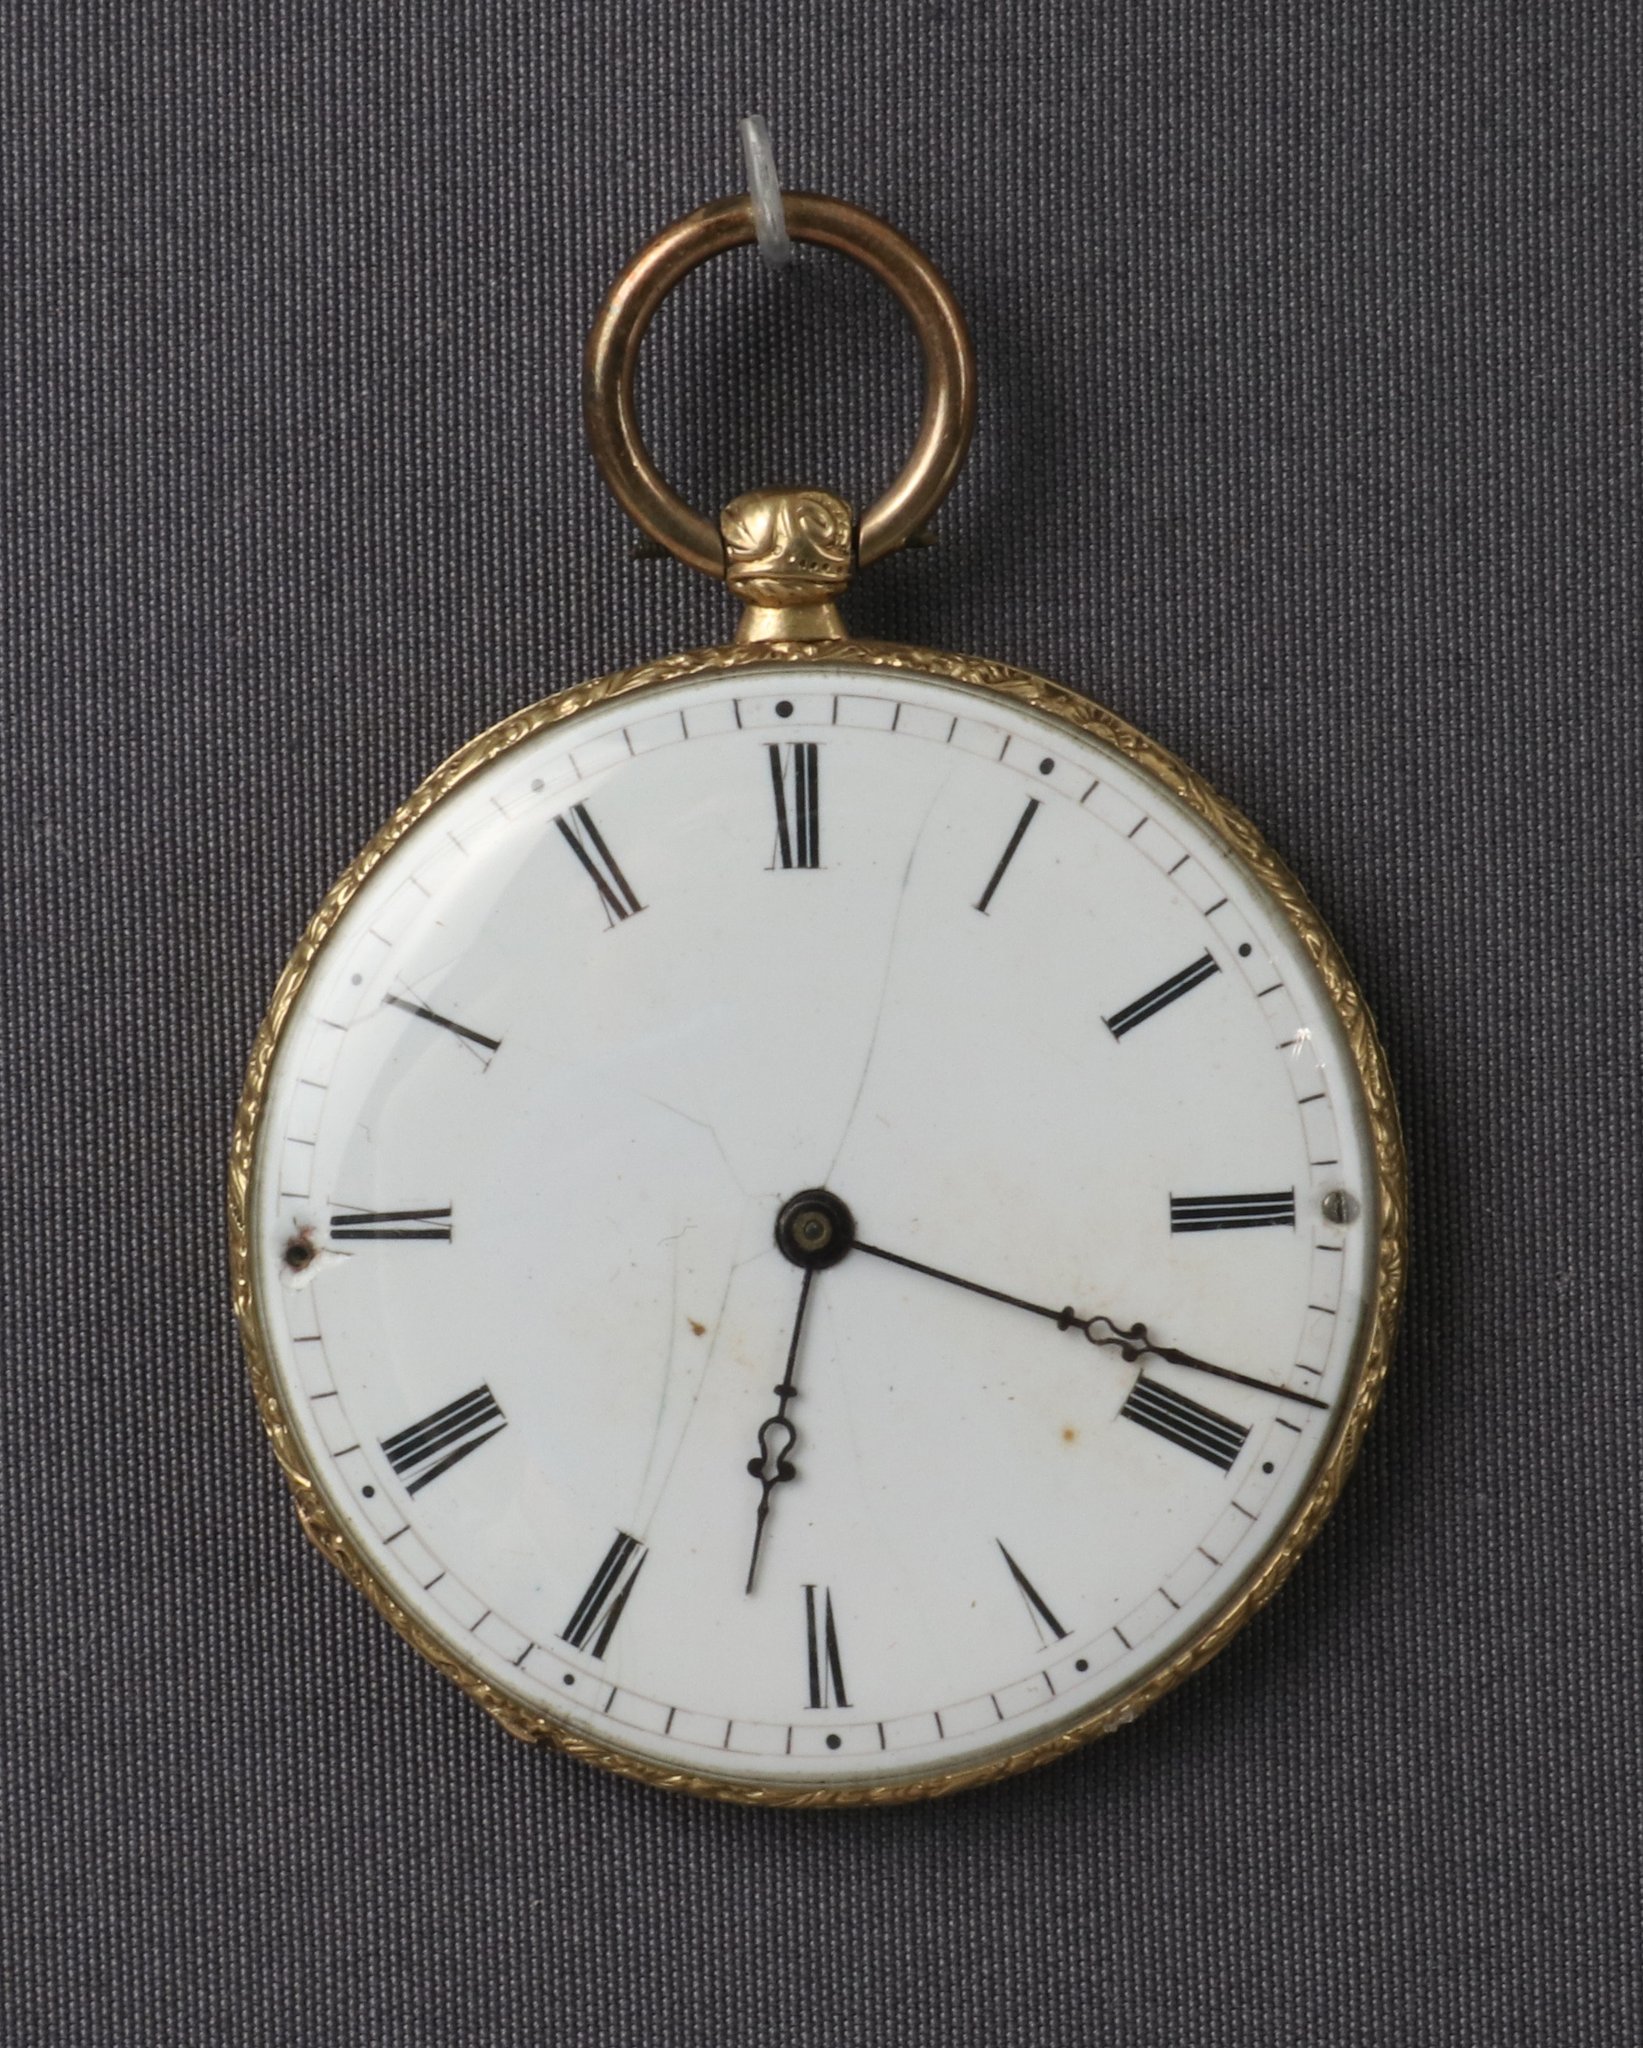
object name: watch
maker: firm of d. bachelard et fils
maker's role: maker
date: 1834-1866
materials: enamel, gold, steel